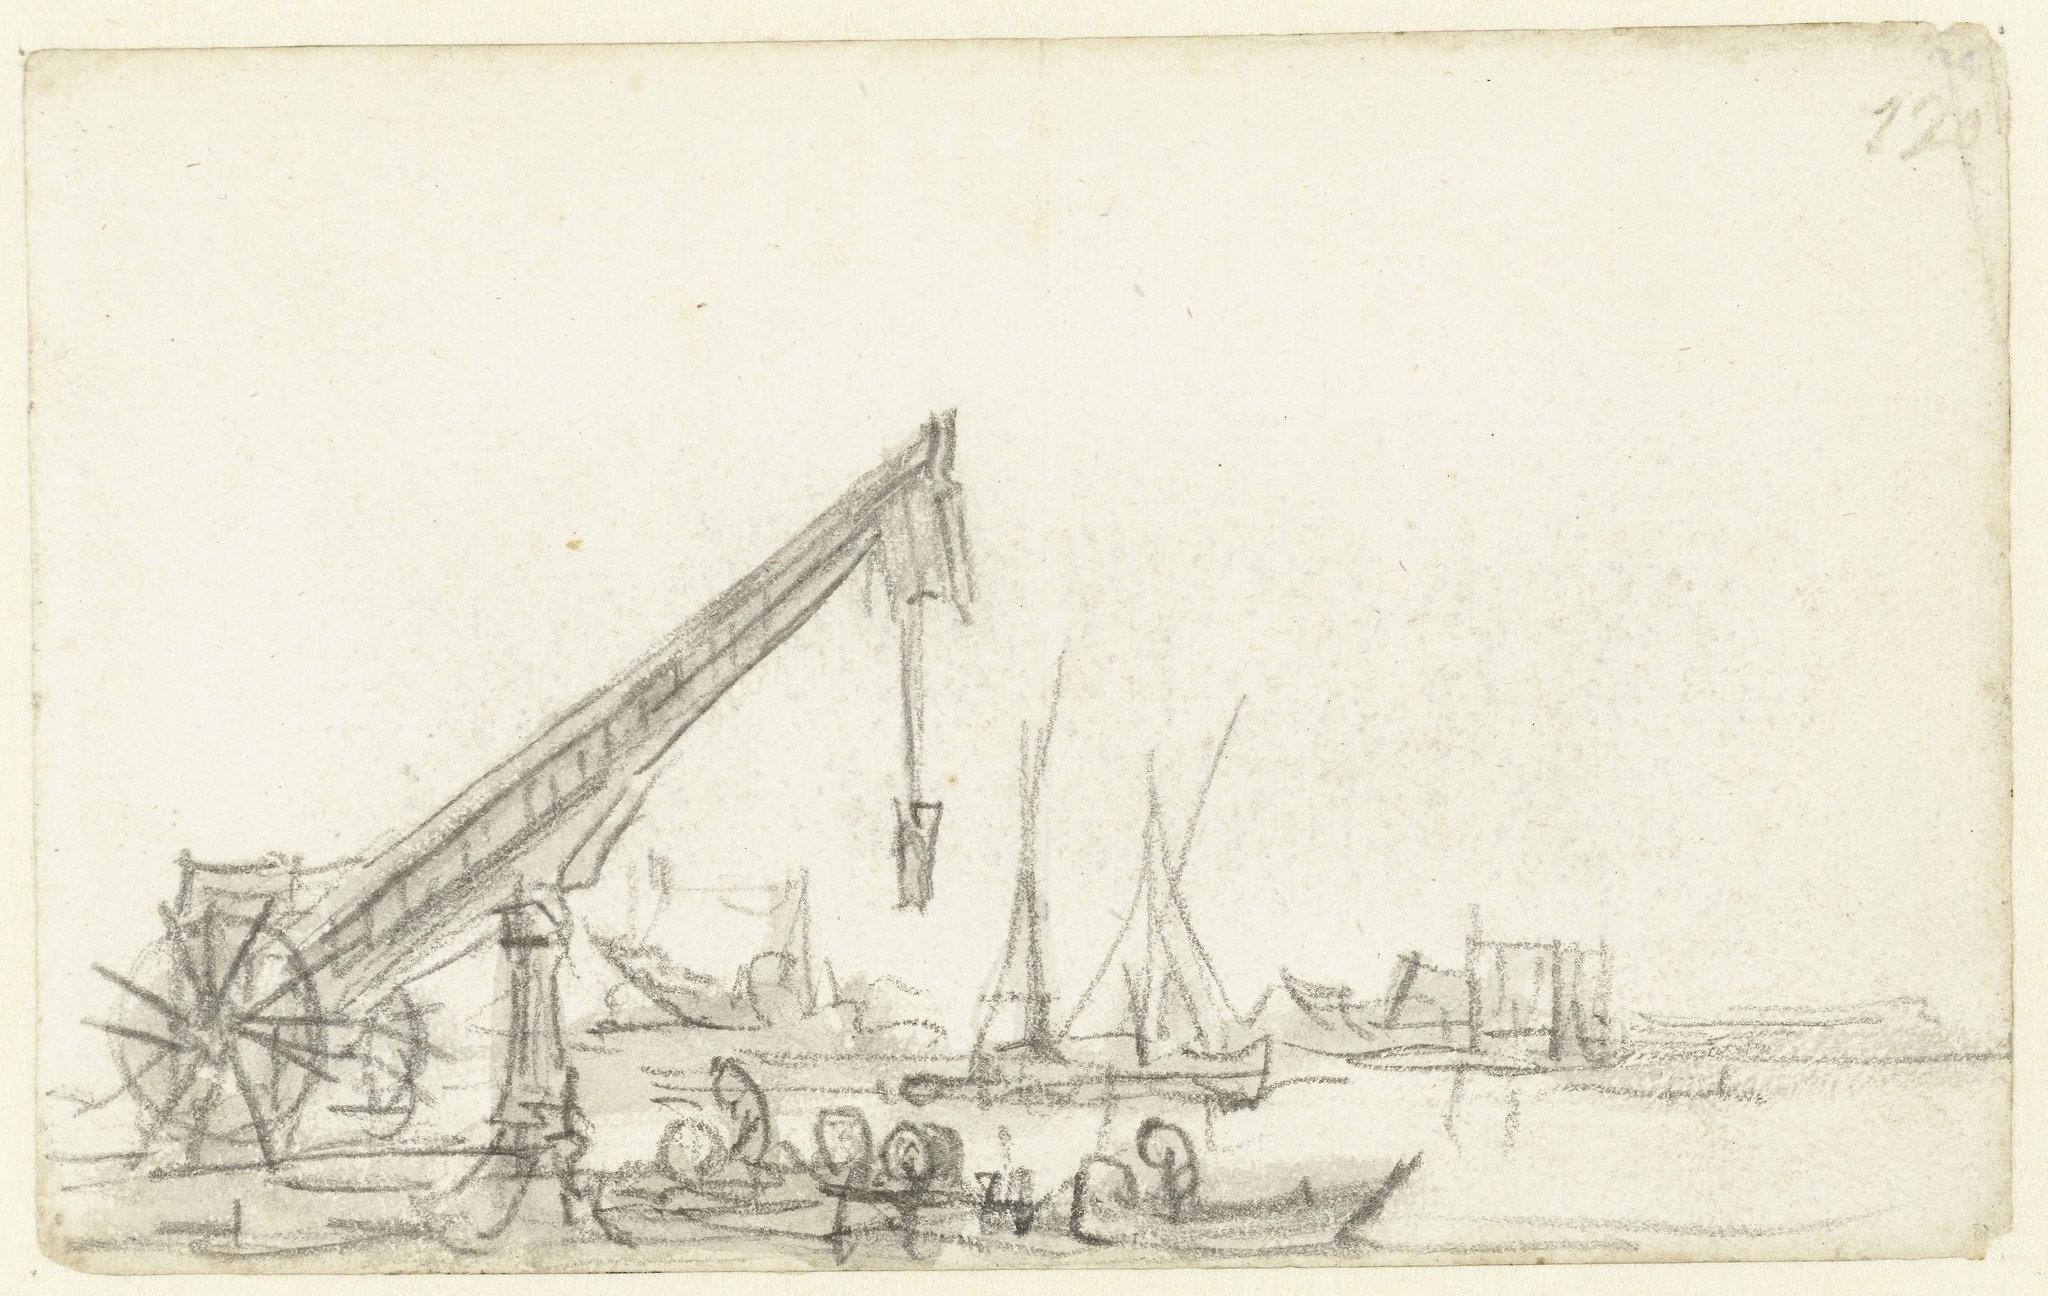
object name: drawing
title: Rivieroever met een hijskraan en enkele boten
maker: jan van goyen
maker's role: draughtsman, painter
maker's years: 1596-1656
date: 1650-1651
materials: chalk, paper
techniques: brush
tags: dock crane, quay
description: Blad afkomstig uit Schetsboek van 165-1651, nr. 120a (210?)